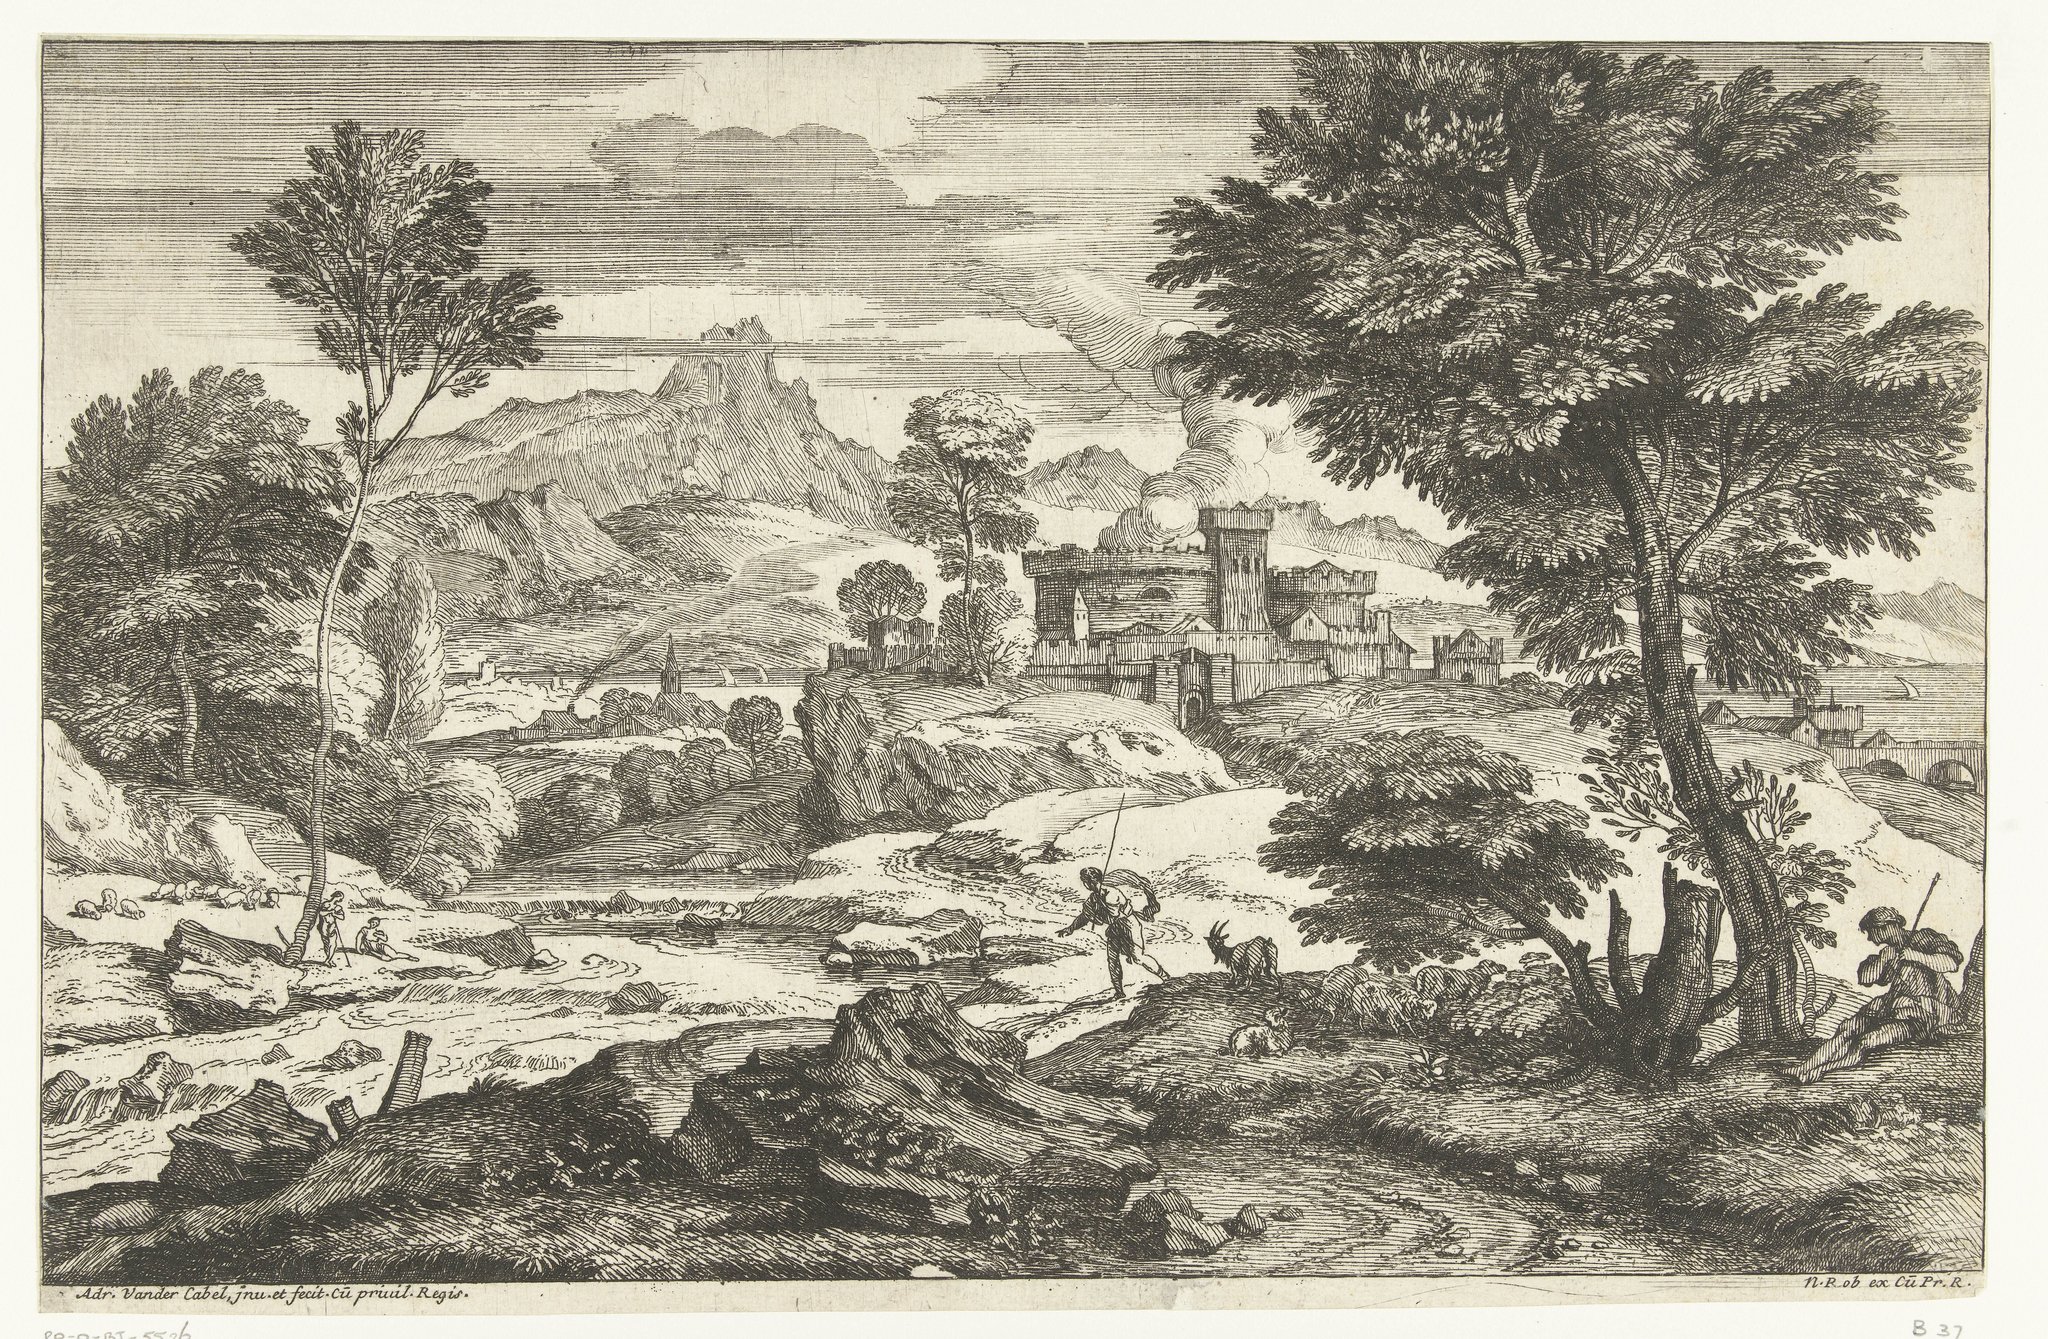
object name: print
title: Landschappen, serie vijf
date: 1648-1705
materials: paper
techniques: etching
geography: france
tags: landscapes, herding, herdsman, herdswoman, shepherd, shepherdess, cowherd, etc., pastorals, arcadian scenes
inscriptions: collector's mark: Lugt 240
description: Landschap met op de voorgrond een pad en een persoon met lange stok zittend onder een boom. Verderop een kudde schapen onder een lage boom en een herder nabij een rivier met aan de overkant twee personen en een tweede kudde schapen. Op de achtergrond een kasteel. Zesde prent uit de serie van zes.